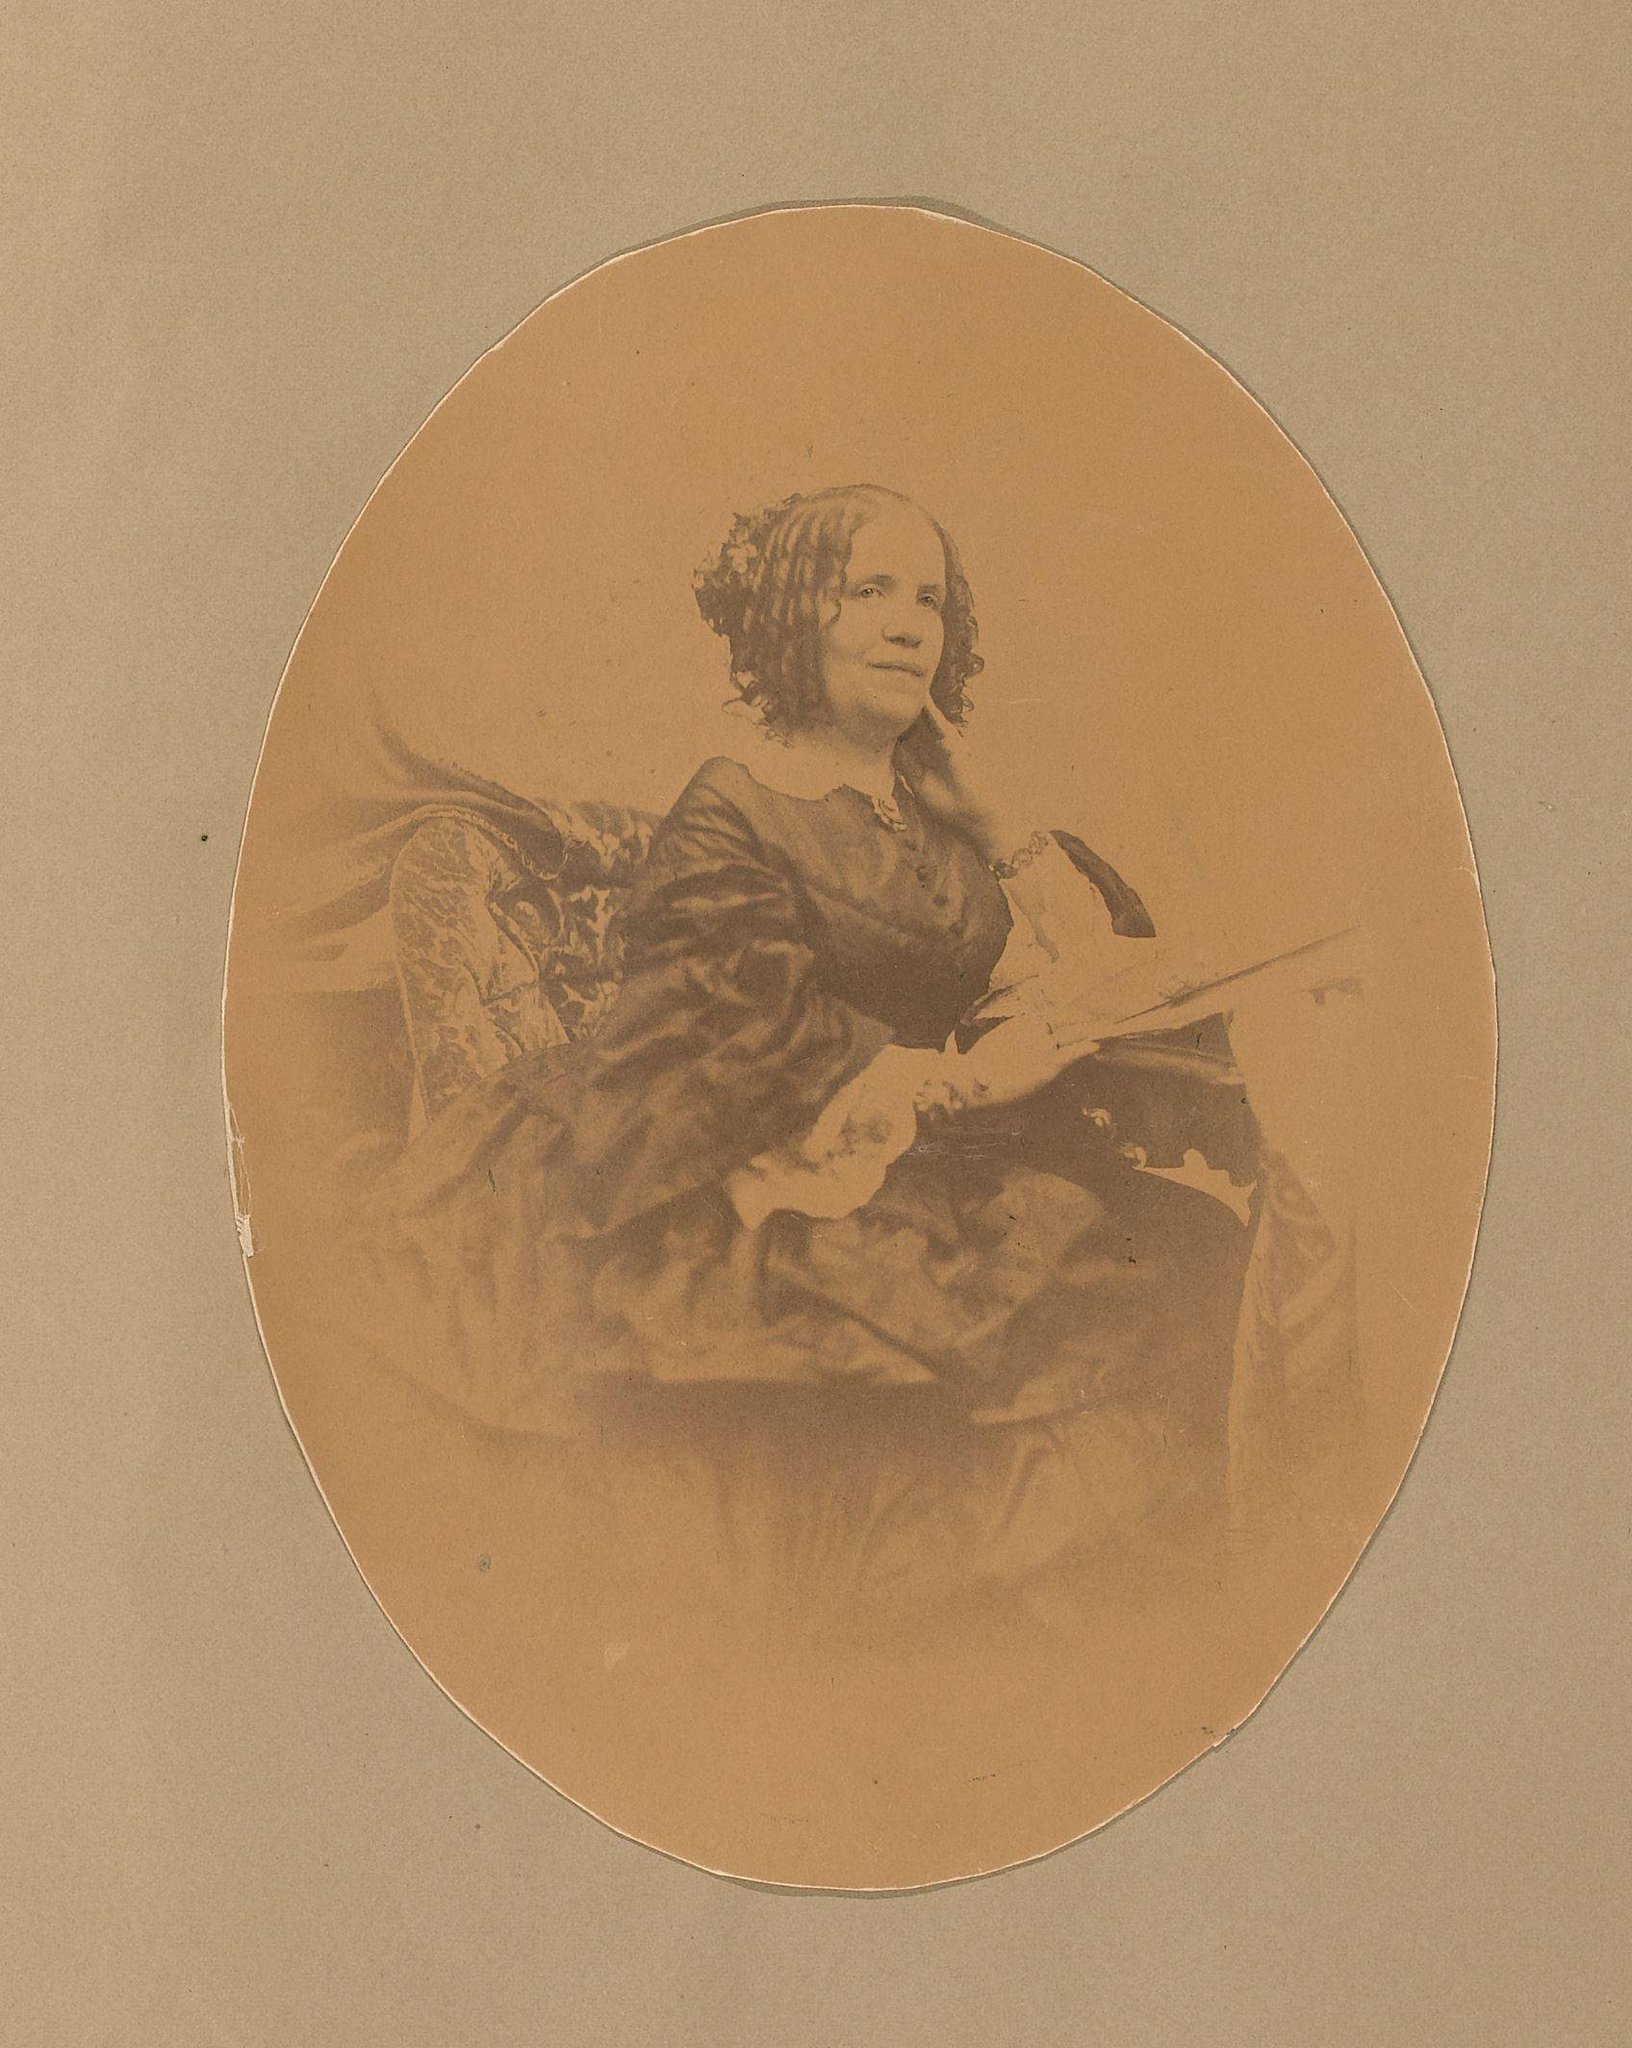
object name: photograph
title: Portret van Euphrosine Asser-Oppenheim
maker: louis wegner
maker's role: print maker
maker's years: 1816-1864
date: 1856-1858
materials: cardboard, paper, photographic support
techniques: salted paper print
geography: amsterdam